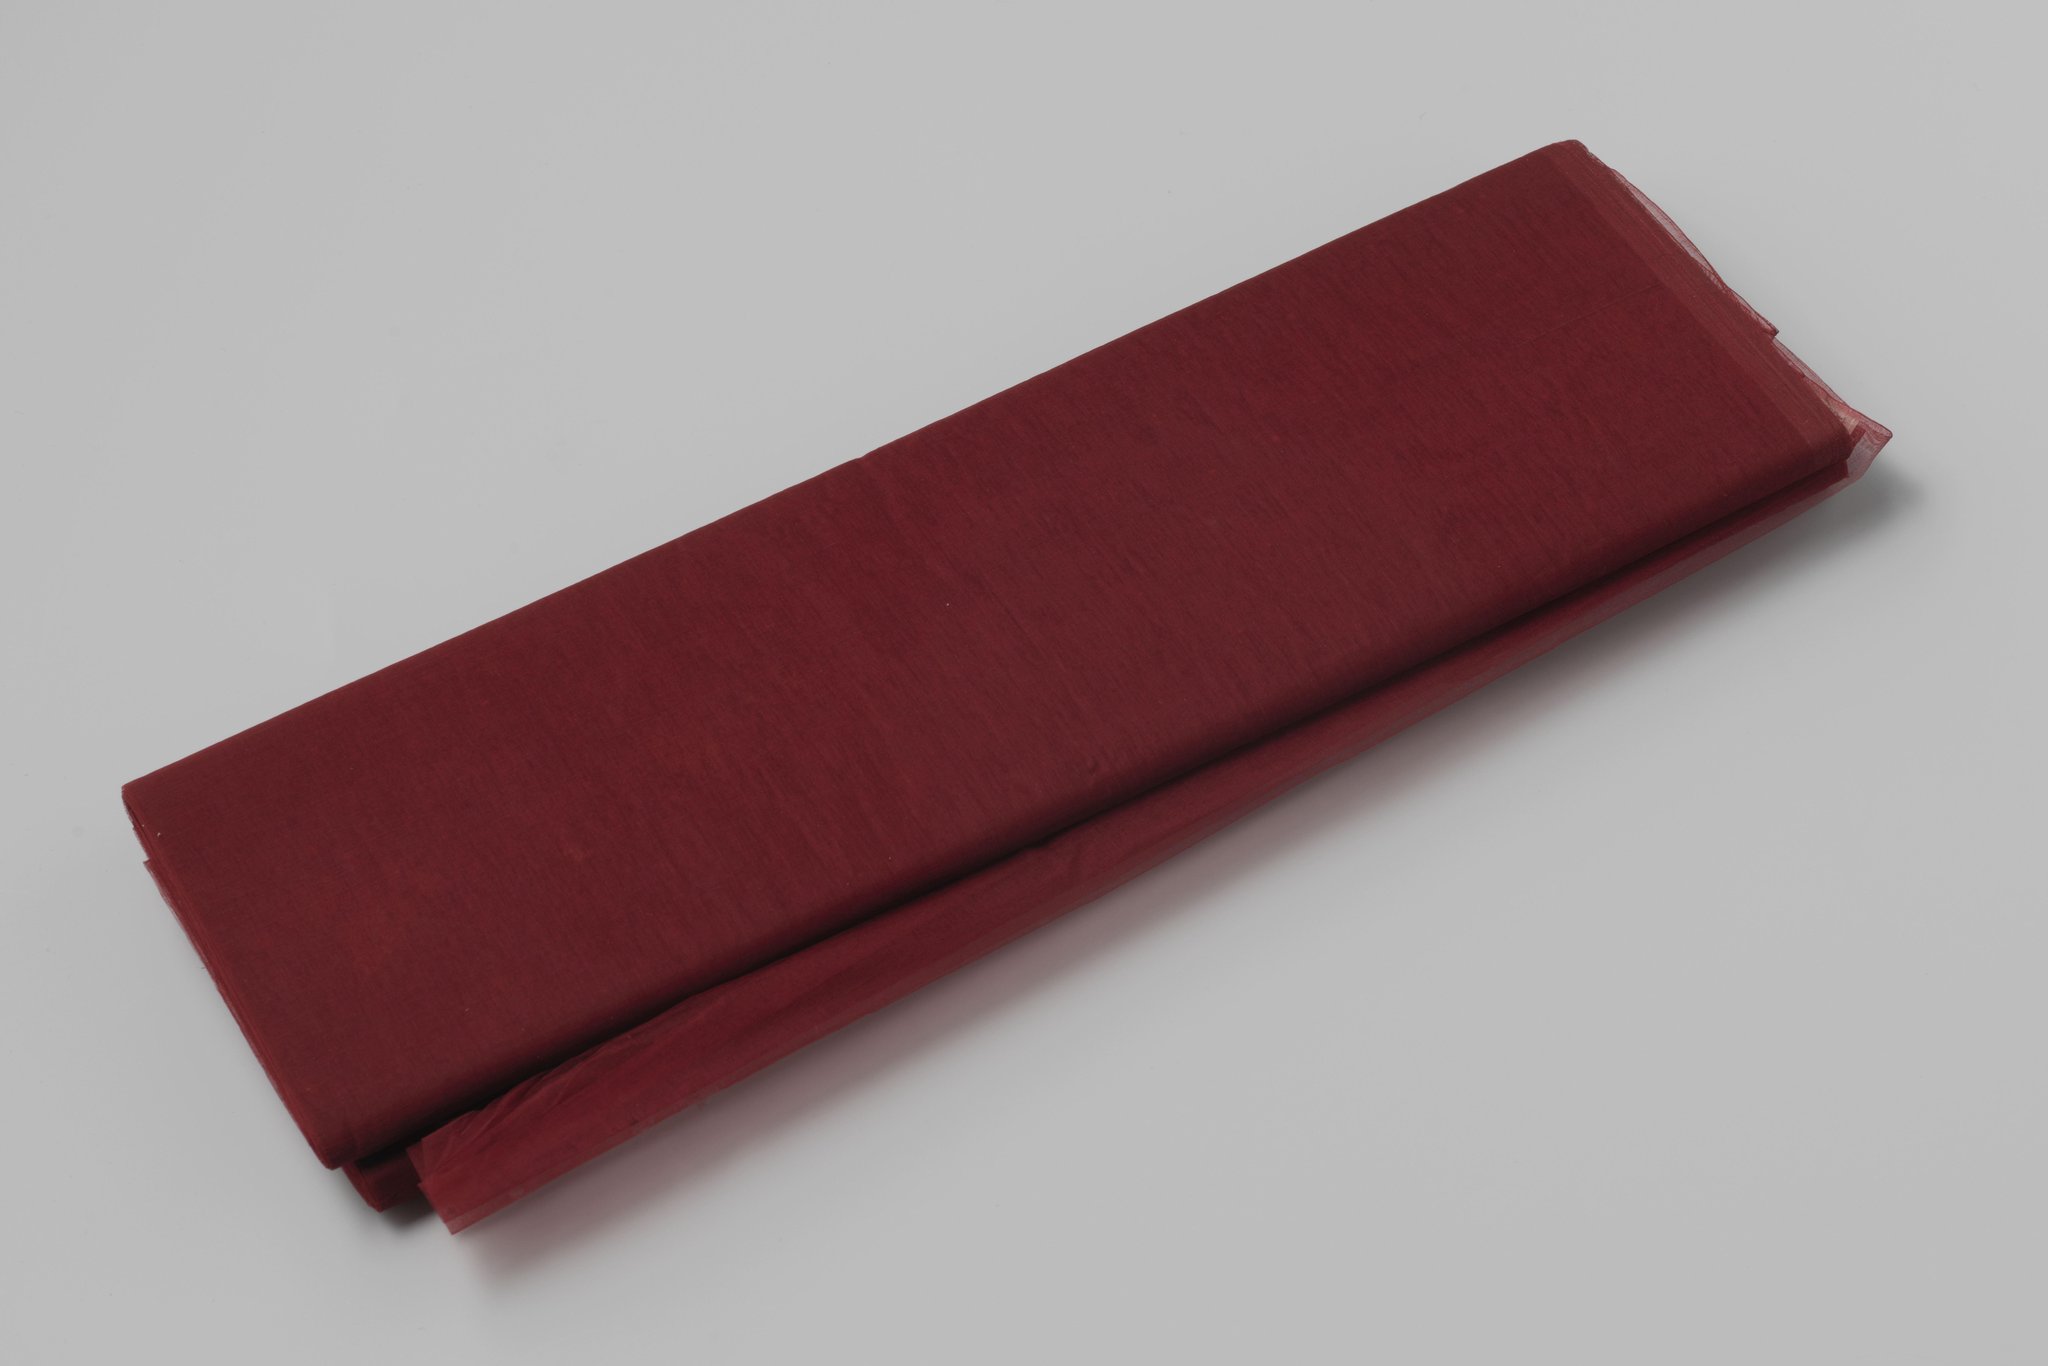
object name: parasolgaas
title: Coupon wijnrood parasolgaas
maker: gustav schnitzler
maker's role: paraplufabrikant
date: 1900-1925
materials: textile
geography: nijmegen